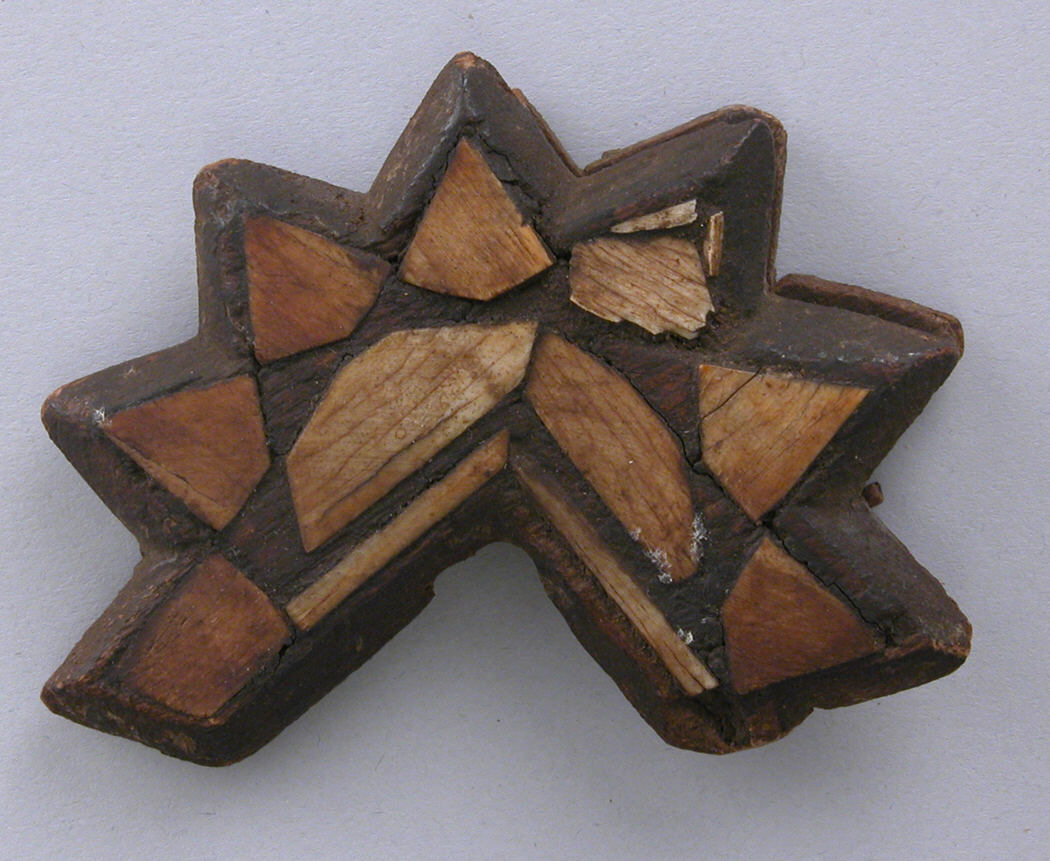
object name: panel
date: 1301-1500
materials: ivory, wood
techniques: inlay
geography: egypt